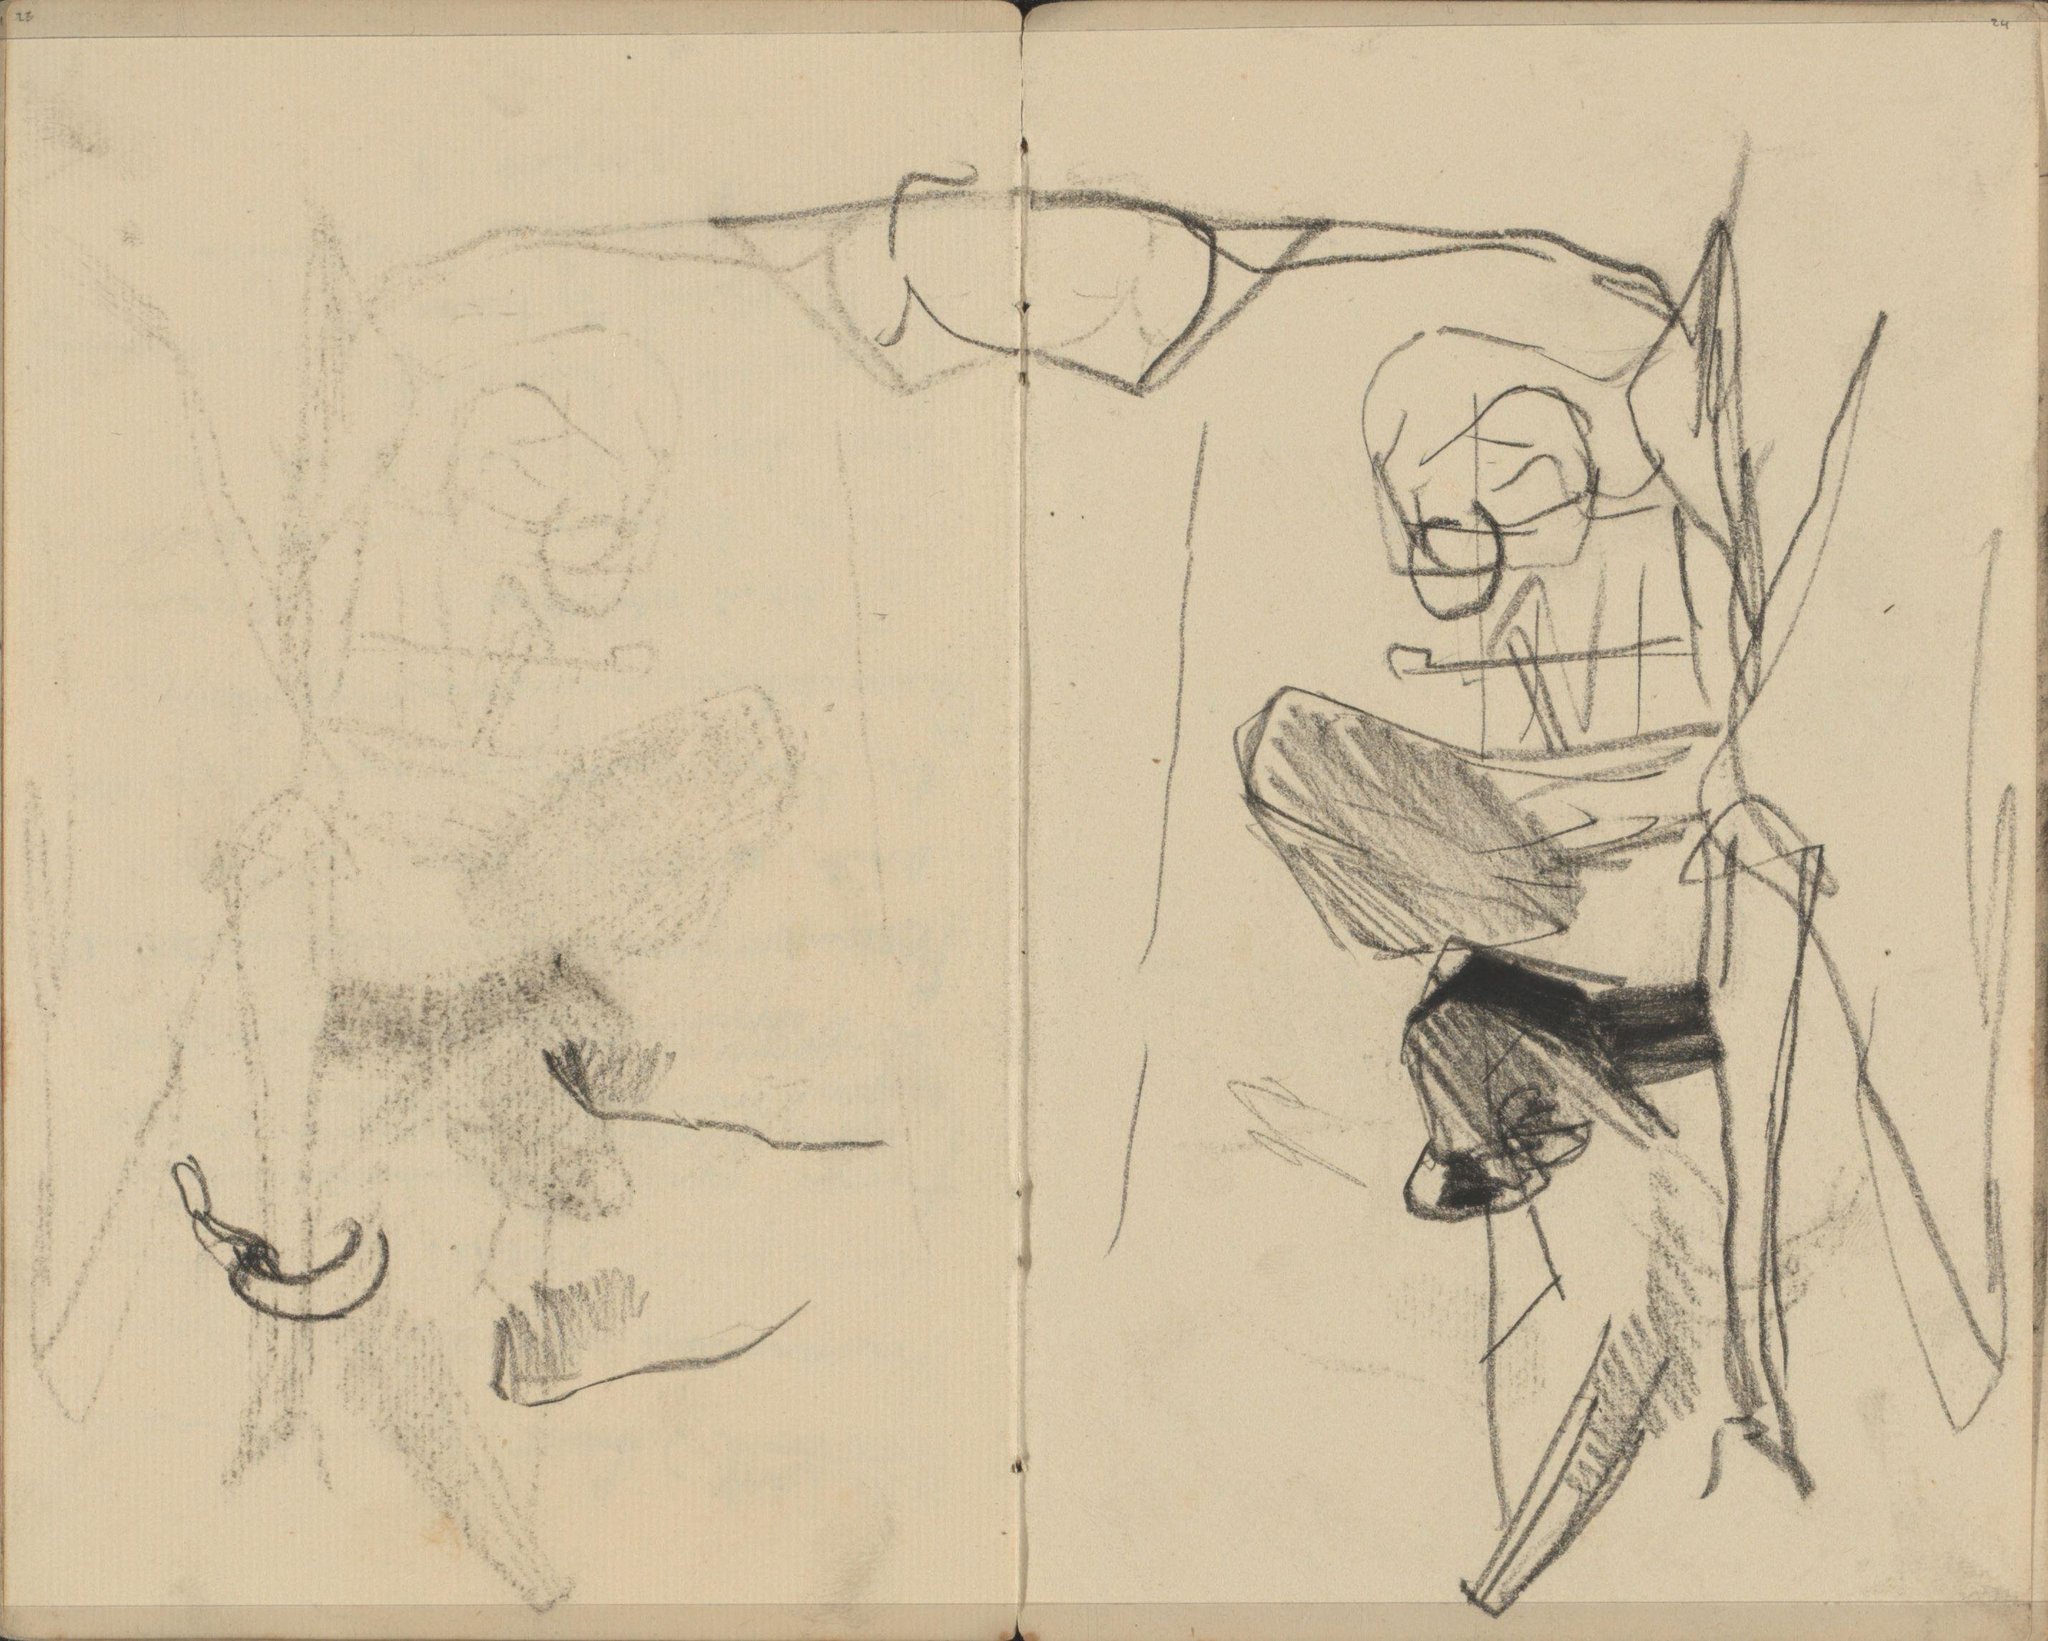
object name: sketchbook leaf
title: Bukkende figuren in een landschap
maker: george hendrik breitner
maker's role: draughtsman, painter, print maker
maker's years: 1857-1923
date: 1882-1884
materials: chalk, paper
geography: the hague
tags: landscapes, bending figure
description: Pagina 23 en pagina 24 uit een schetsboek met 24 bladen.